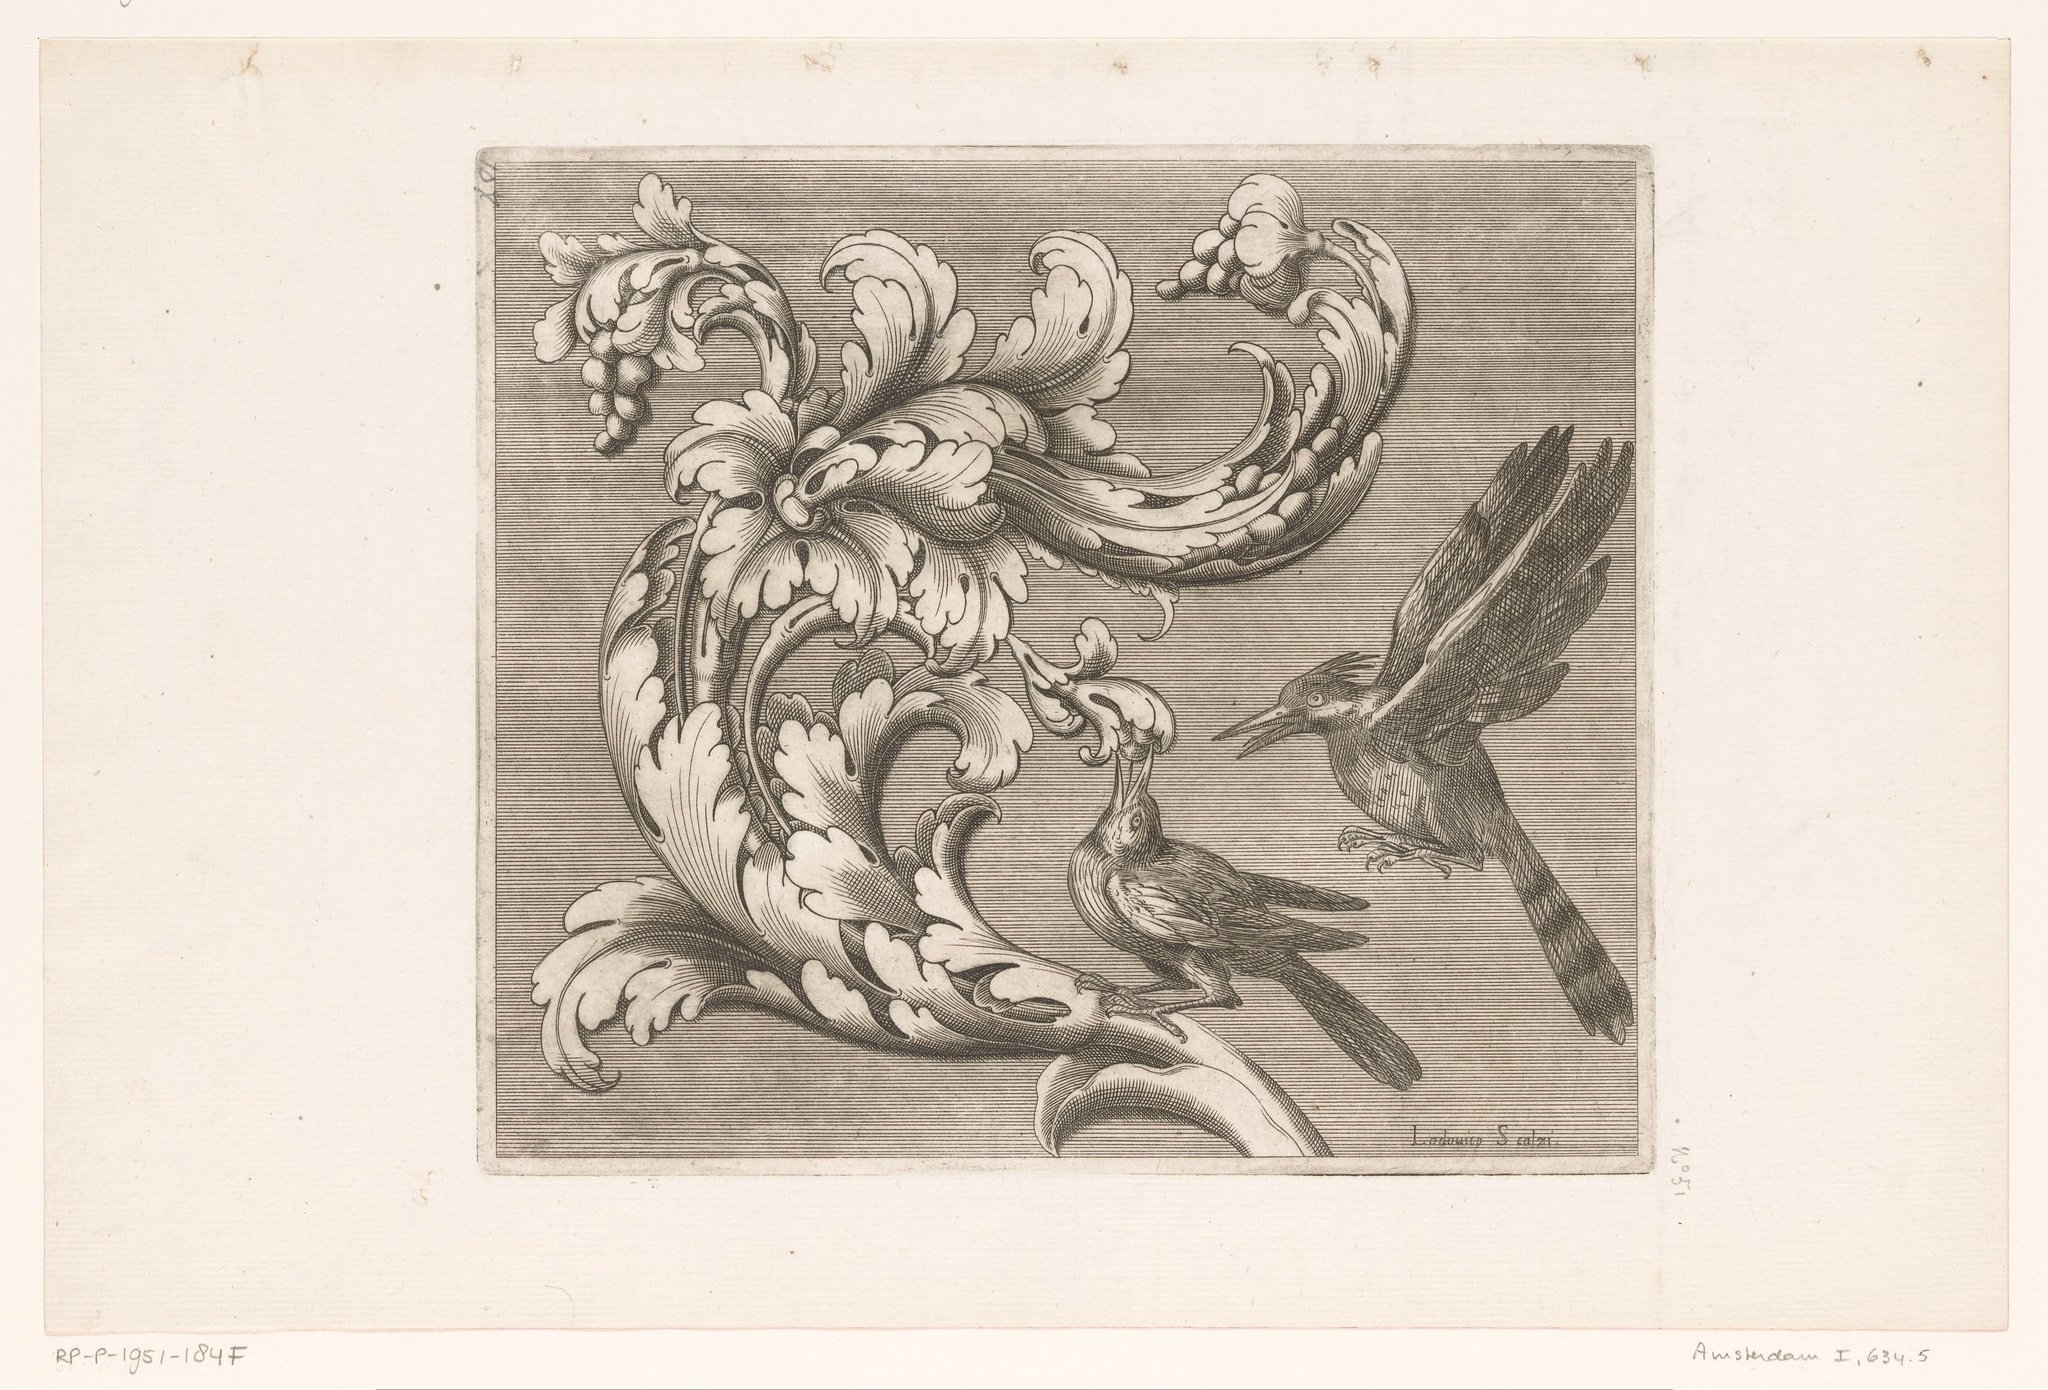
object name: ornament print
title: Acanthusmotief met twee vogels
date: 1589-1614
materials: paper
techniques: engraving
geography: italy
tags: acanthus ~ ornament - aa - stylized, birds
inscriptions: collector's mark: Lugt 2228